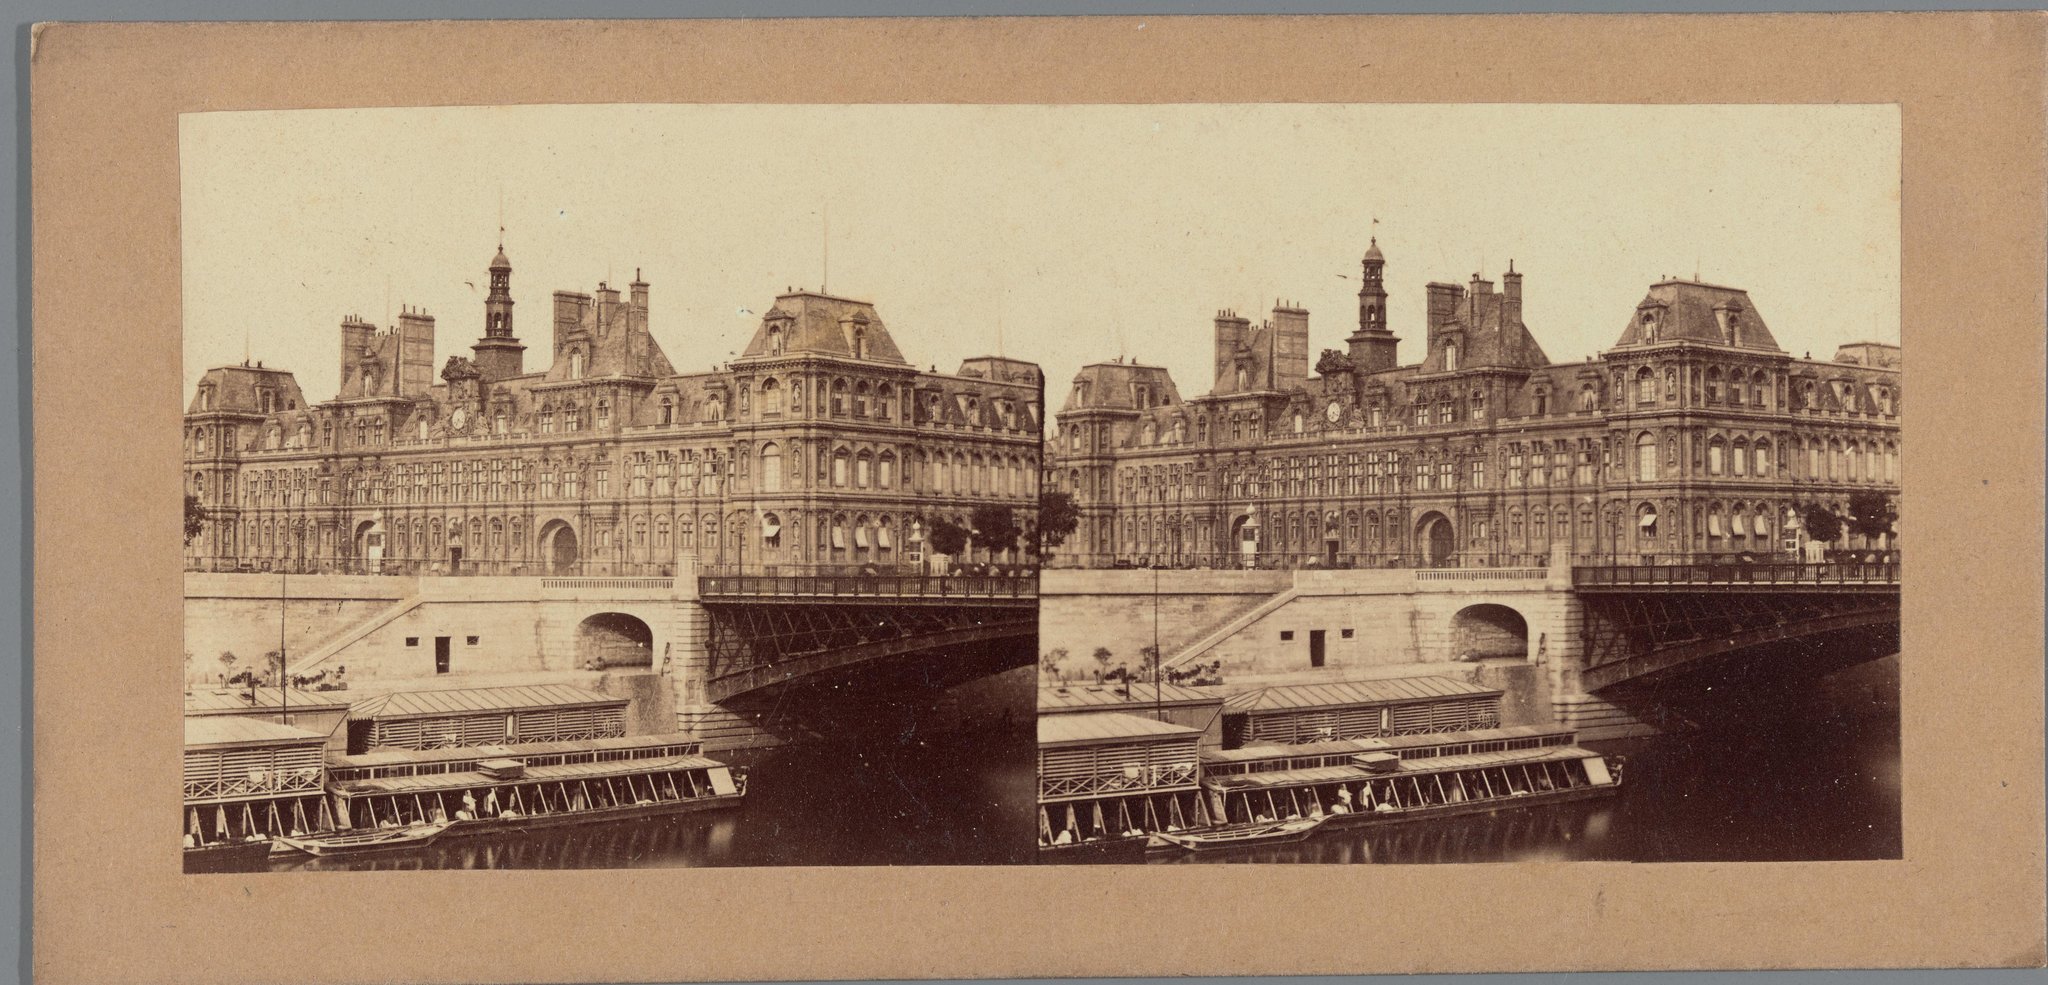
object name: stereograph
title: Stadhuis van Parijs gezien over de Seine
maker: Anonymous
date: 1860-1880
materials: cardboard, paper, photographic support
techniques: albumen print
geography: paris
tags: townhall, paris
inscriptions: inscription: ‘Banselin opticien Ft. 14. R. de Seine. Paris.’